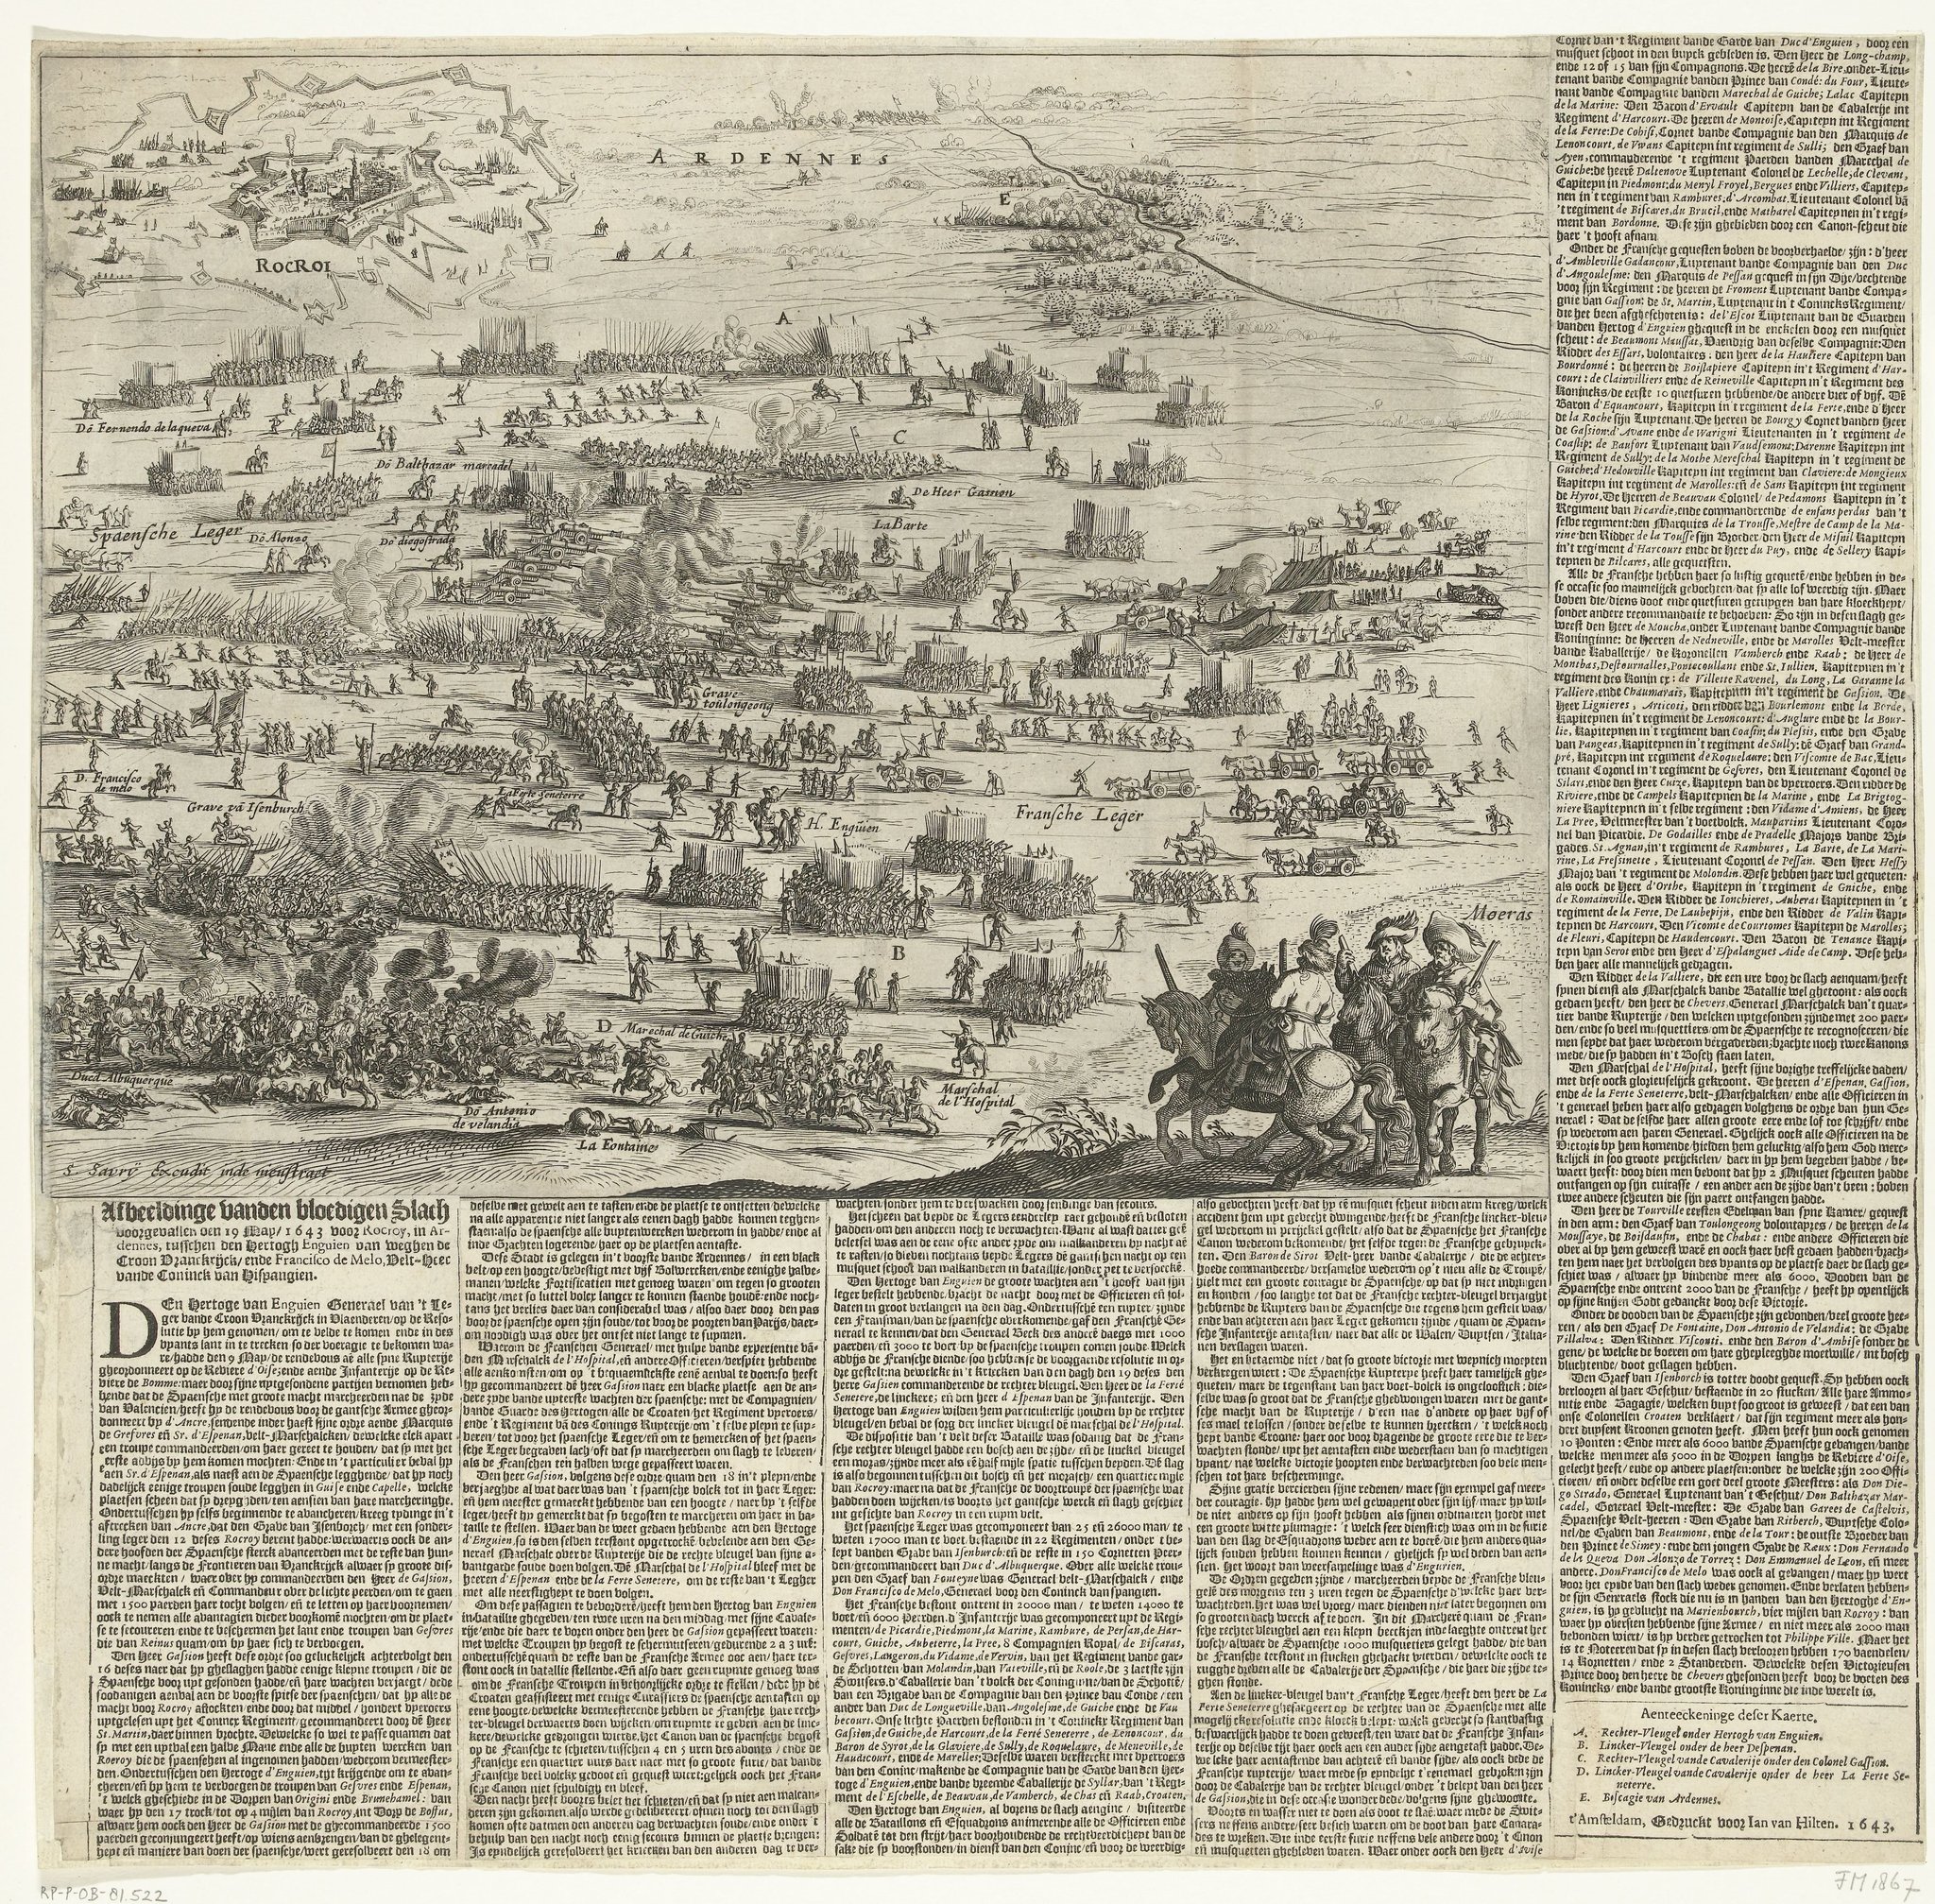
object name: print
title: Slag bij Rocroi, 1643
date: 1643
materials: paper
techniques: engraving, etching, letterpress printing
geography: amsterdam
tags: paris, lodewijk ii de bourbon-condé (hertog van enghien), battle (+ land forces)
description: Slag bij Rocroi in de Franse Ardennen op 19 mei 1643 waarbij het Franse leger onder Lodewijk II van Bourbon-Condé, de hertog van Enghien, het Spaanse leger onder bevel van Francisco de Melo een nederlaag toebracht. Voorstelling van de veldslag, op de voorgrond enkele ruiters. Op het papier rond de prent zijn 5 kolommen tekst in het Nederlands geplakt.